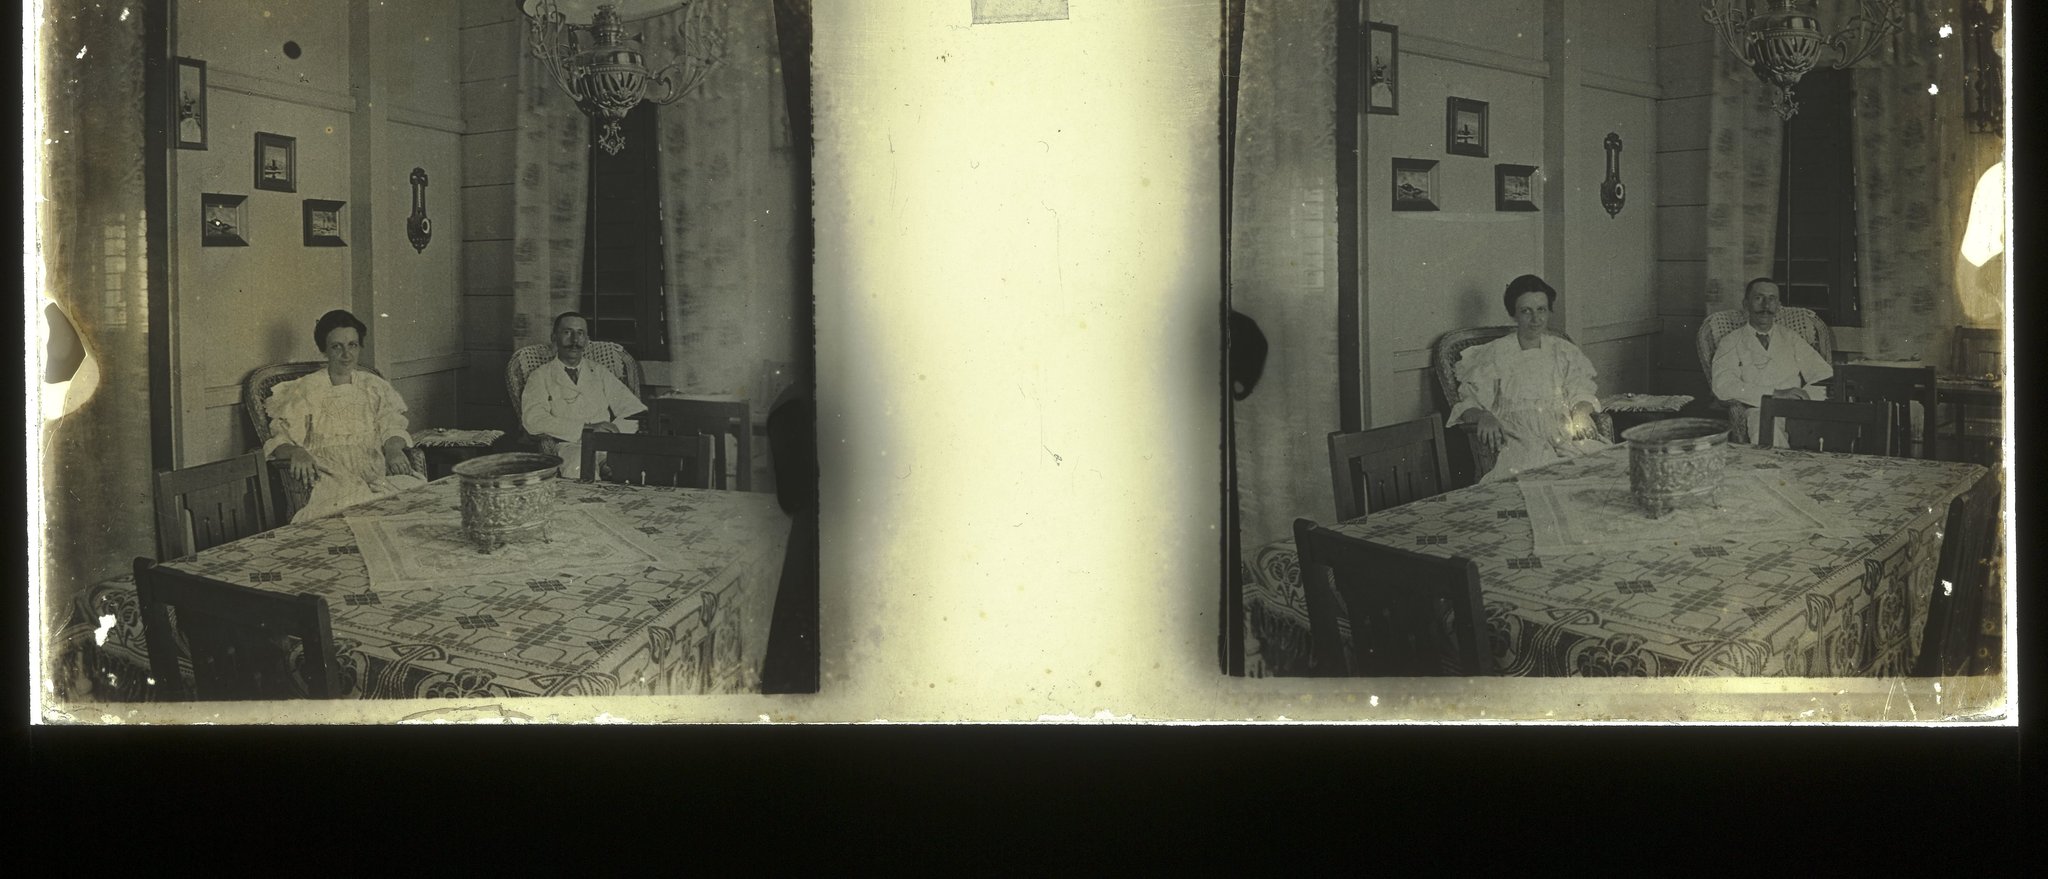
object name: stereograph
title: Een familie in Suriname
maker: theodoor brouwers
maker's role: amateurfotograaf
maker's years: 1874-1932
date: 1913-1930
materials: glass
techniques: photography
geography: suriname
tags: amsterdam, theodoor brouwers, suriname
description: In de periode 1911-1932 woonde op plantage Accaribo in Suriname de familie Brouwers van wie de foto's afkomstig zijn. Rond 1910 vond Theodoor Brouwers werk op plantage Accaribo. In 1929 werd hij eigenaar van de plantage. Op Accaribo werden in zijn tijd bananen geproduceerd en wat koffie.